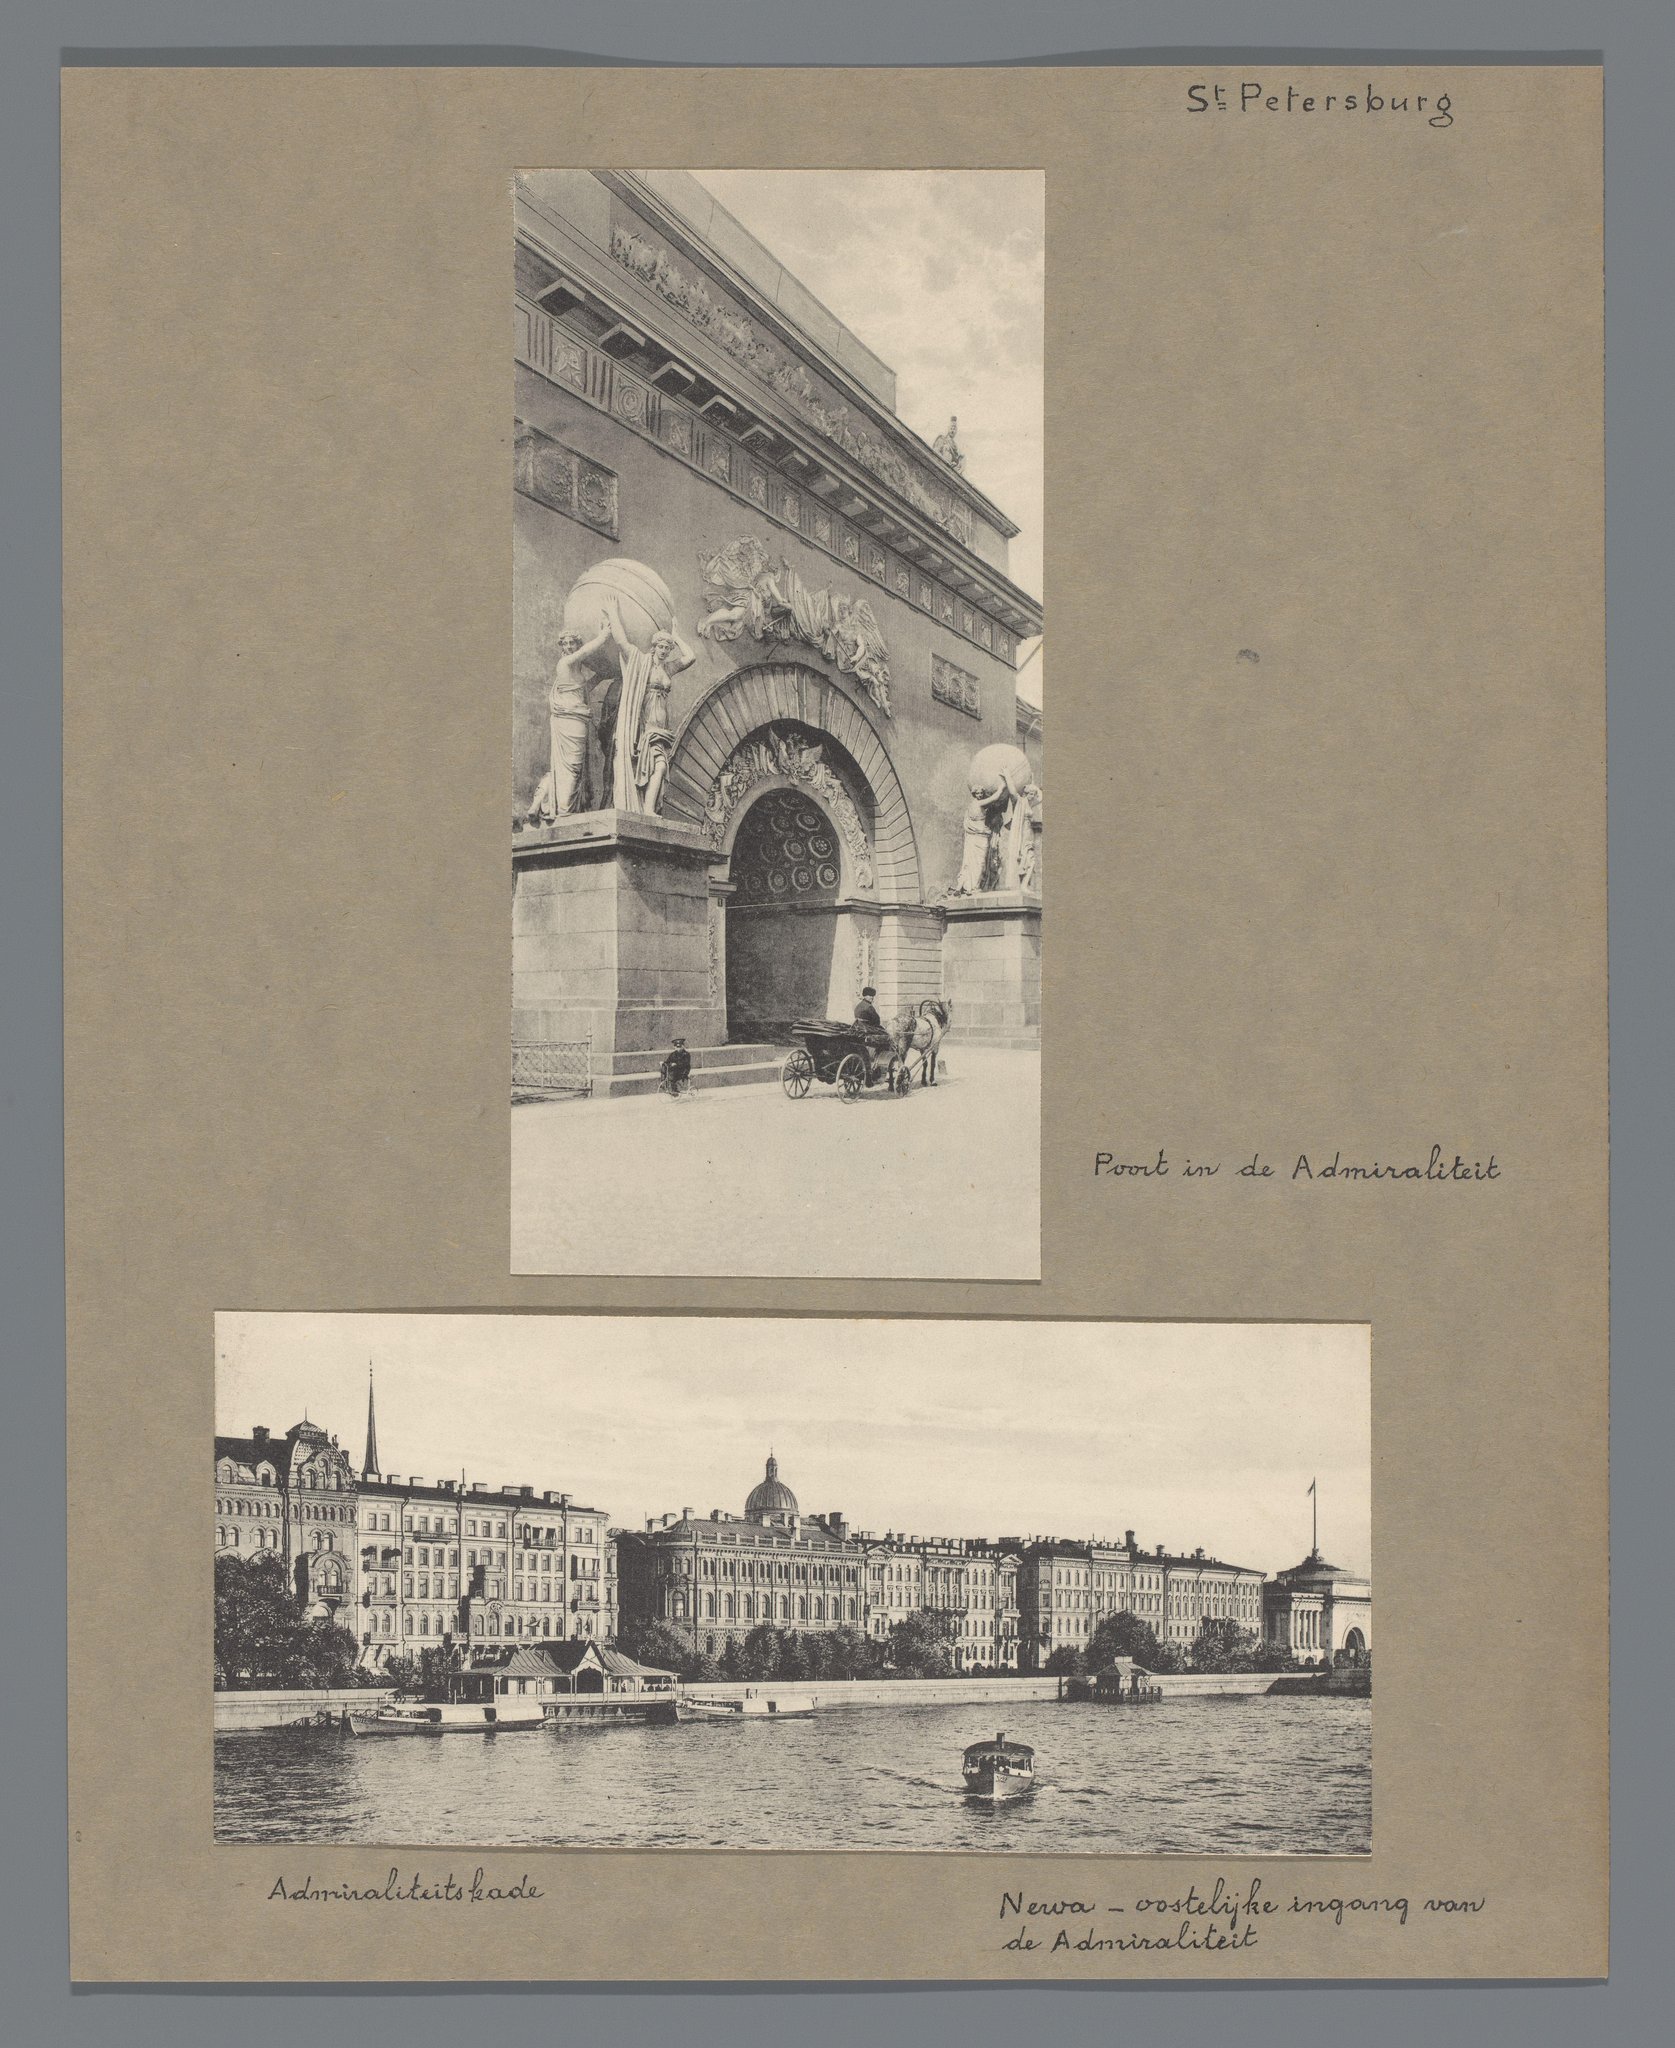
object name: photograph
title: St. Petersburg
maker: Anonymous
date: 1860-1925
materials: photographic support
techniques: photograph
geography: russia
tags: sint-petersburg